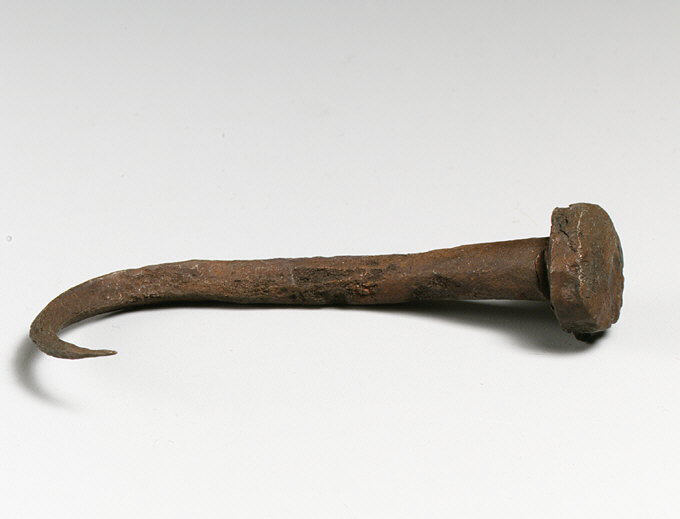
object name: nail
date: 7000 BCE-330 CE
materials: bronze